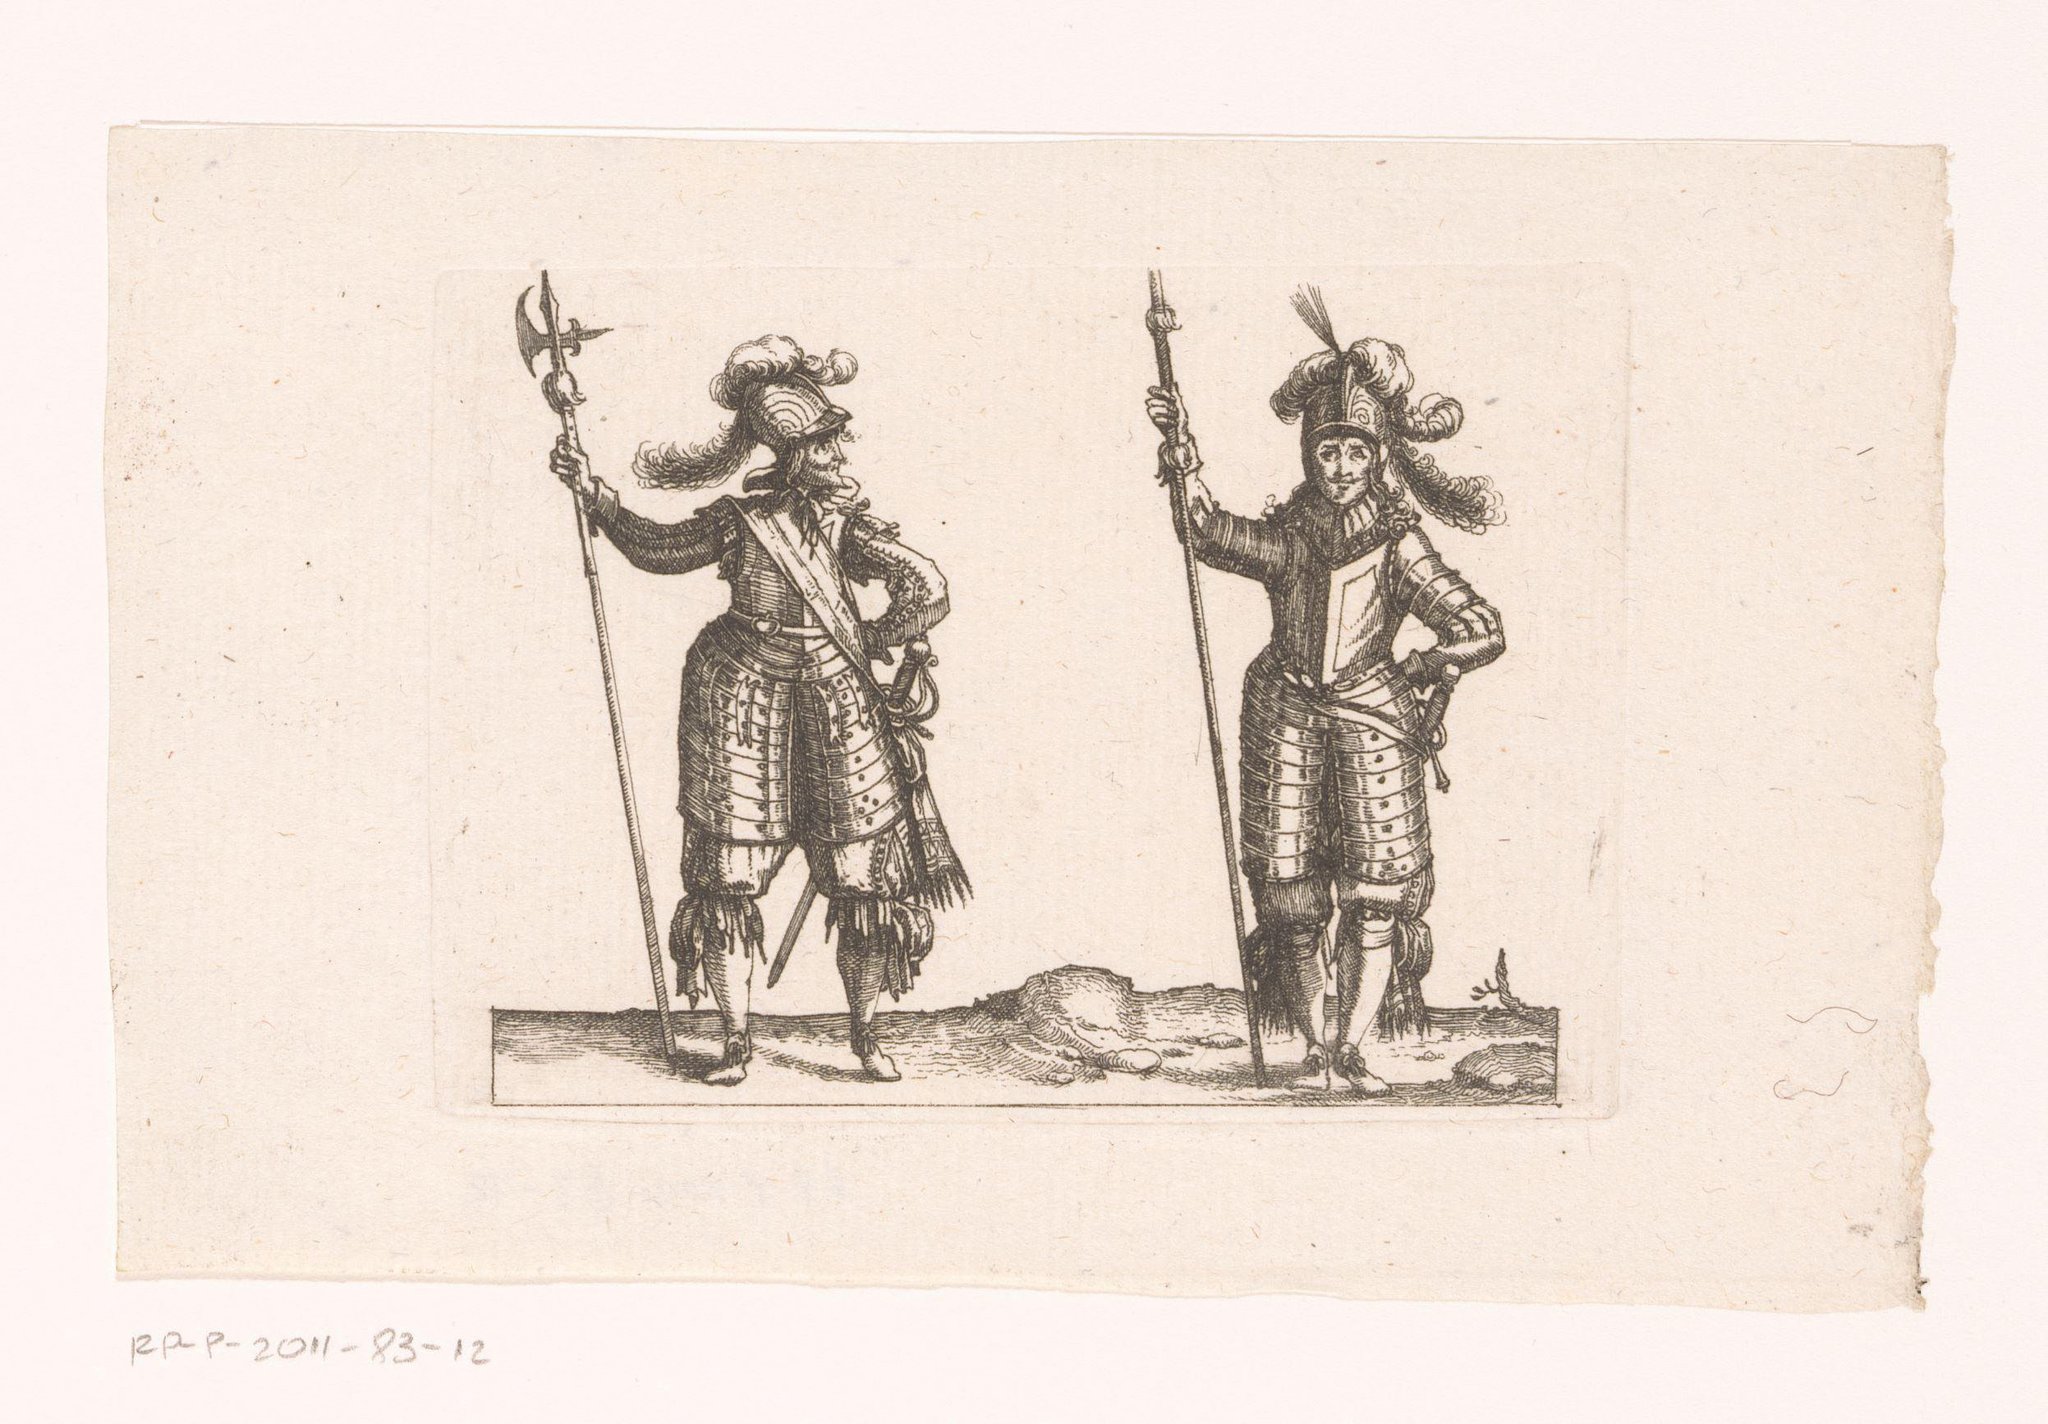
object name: print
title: Soldaten en edelmannen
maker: rudolph meyer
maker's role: print maker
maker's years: 1605-1638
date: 1615-1638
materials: paper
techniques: etching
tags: helved weapons, polearms (for striking, hacking, thrusting): pike, armour, the soldier; the soldier's life, helved weapons, polearms (for striking, hacking, thrusting): halberd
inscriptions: collector's mark, collector's mark: Lugt 2228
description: Onderdeel van een serie van zestien voorstellingen van soldaten (Soldatenbüchli).